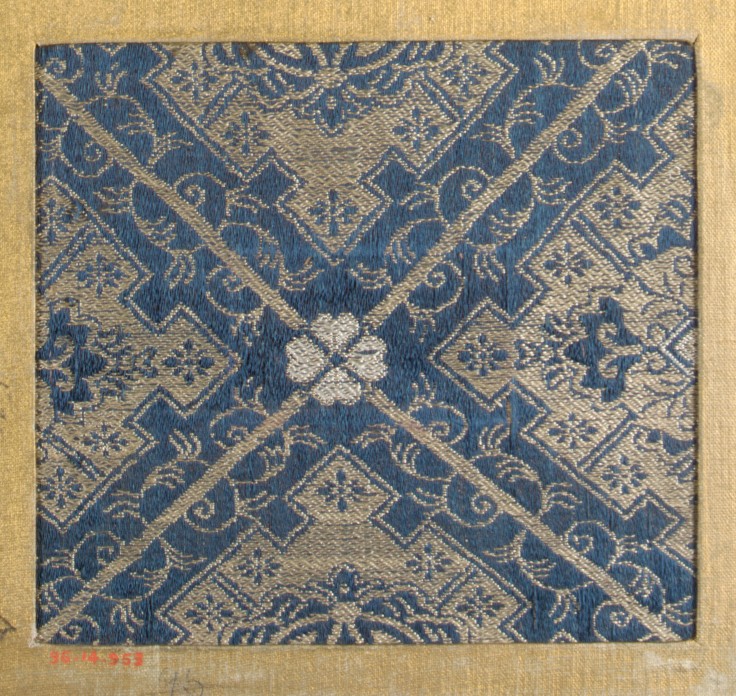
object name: piece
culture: japanese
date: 1701-1900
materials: silk